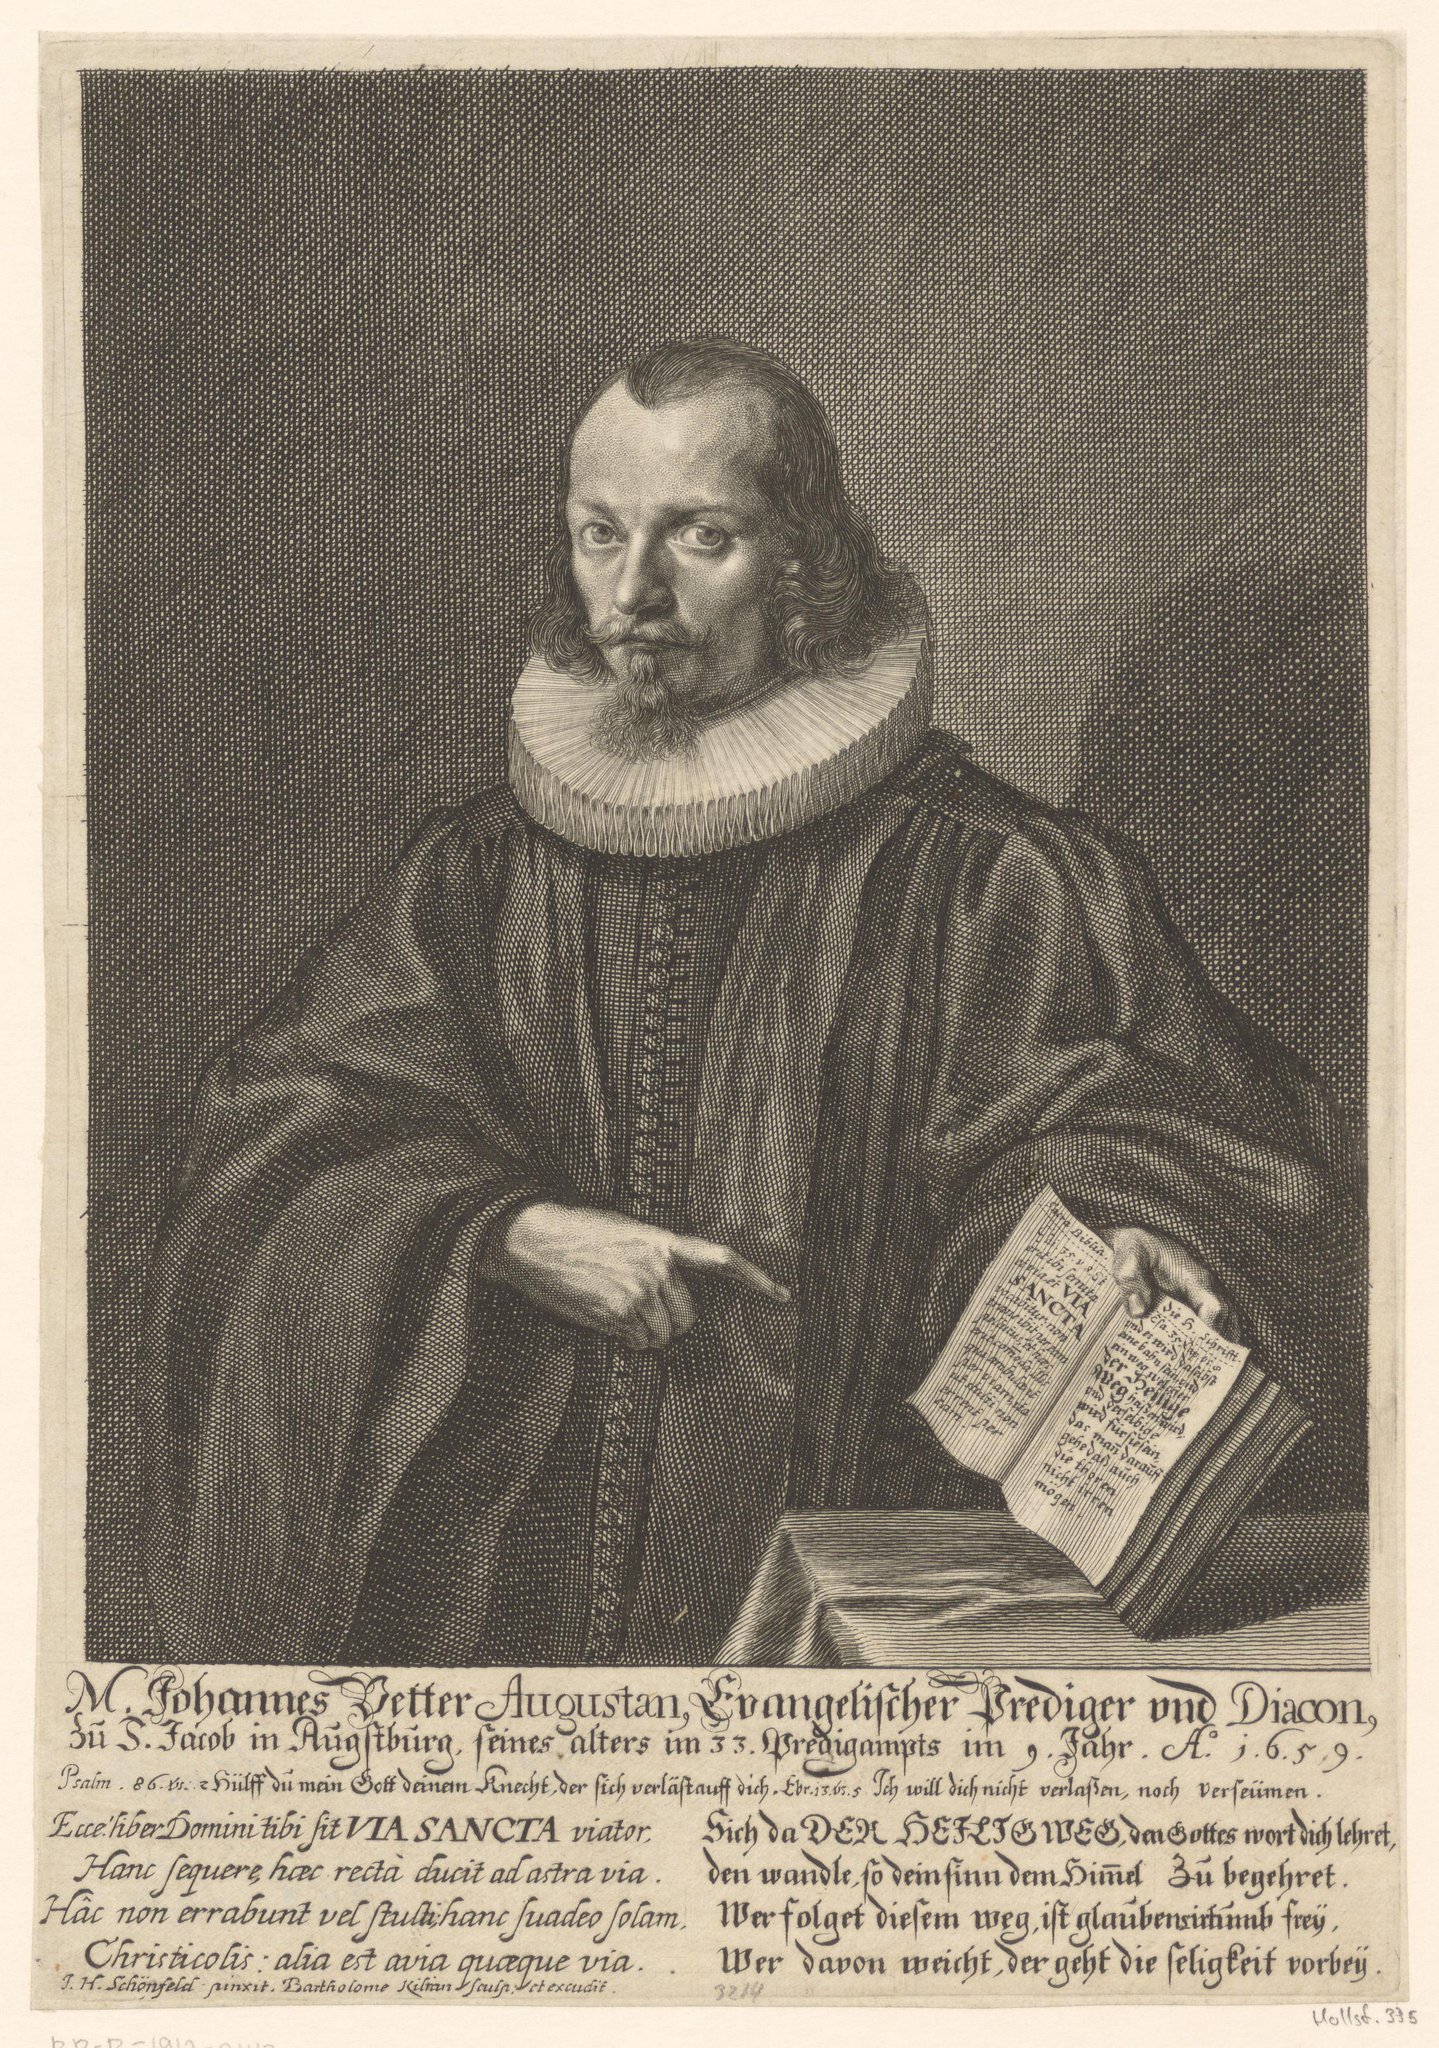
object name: print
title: Portret van Johannes Vetter op 33-jarige leeftijd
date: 1659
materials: paper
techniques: engraving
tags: theologian, historical persons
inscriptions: collector's mark: Lugt 2228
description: In de marge informatie over de geportretteerde en passages uit de Bijbel in het Duits.